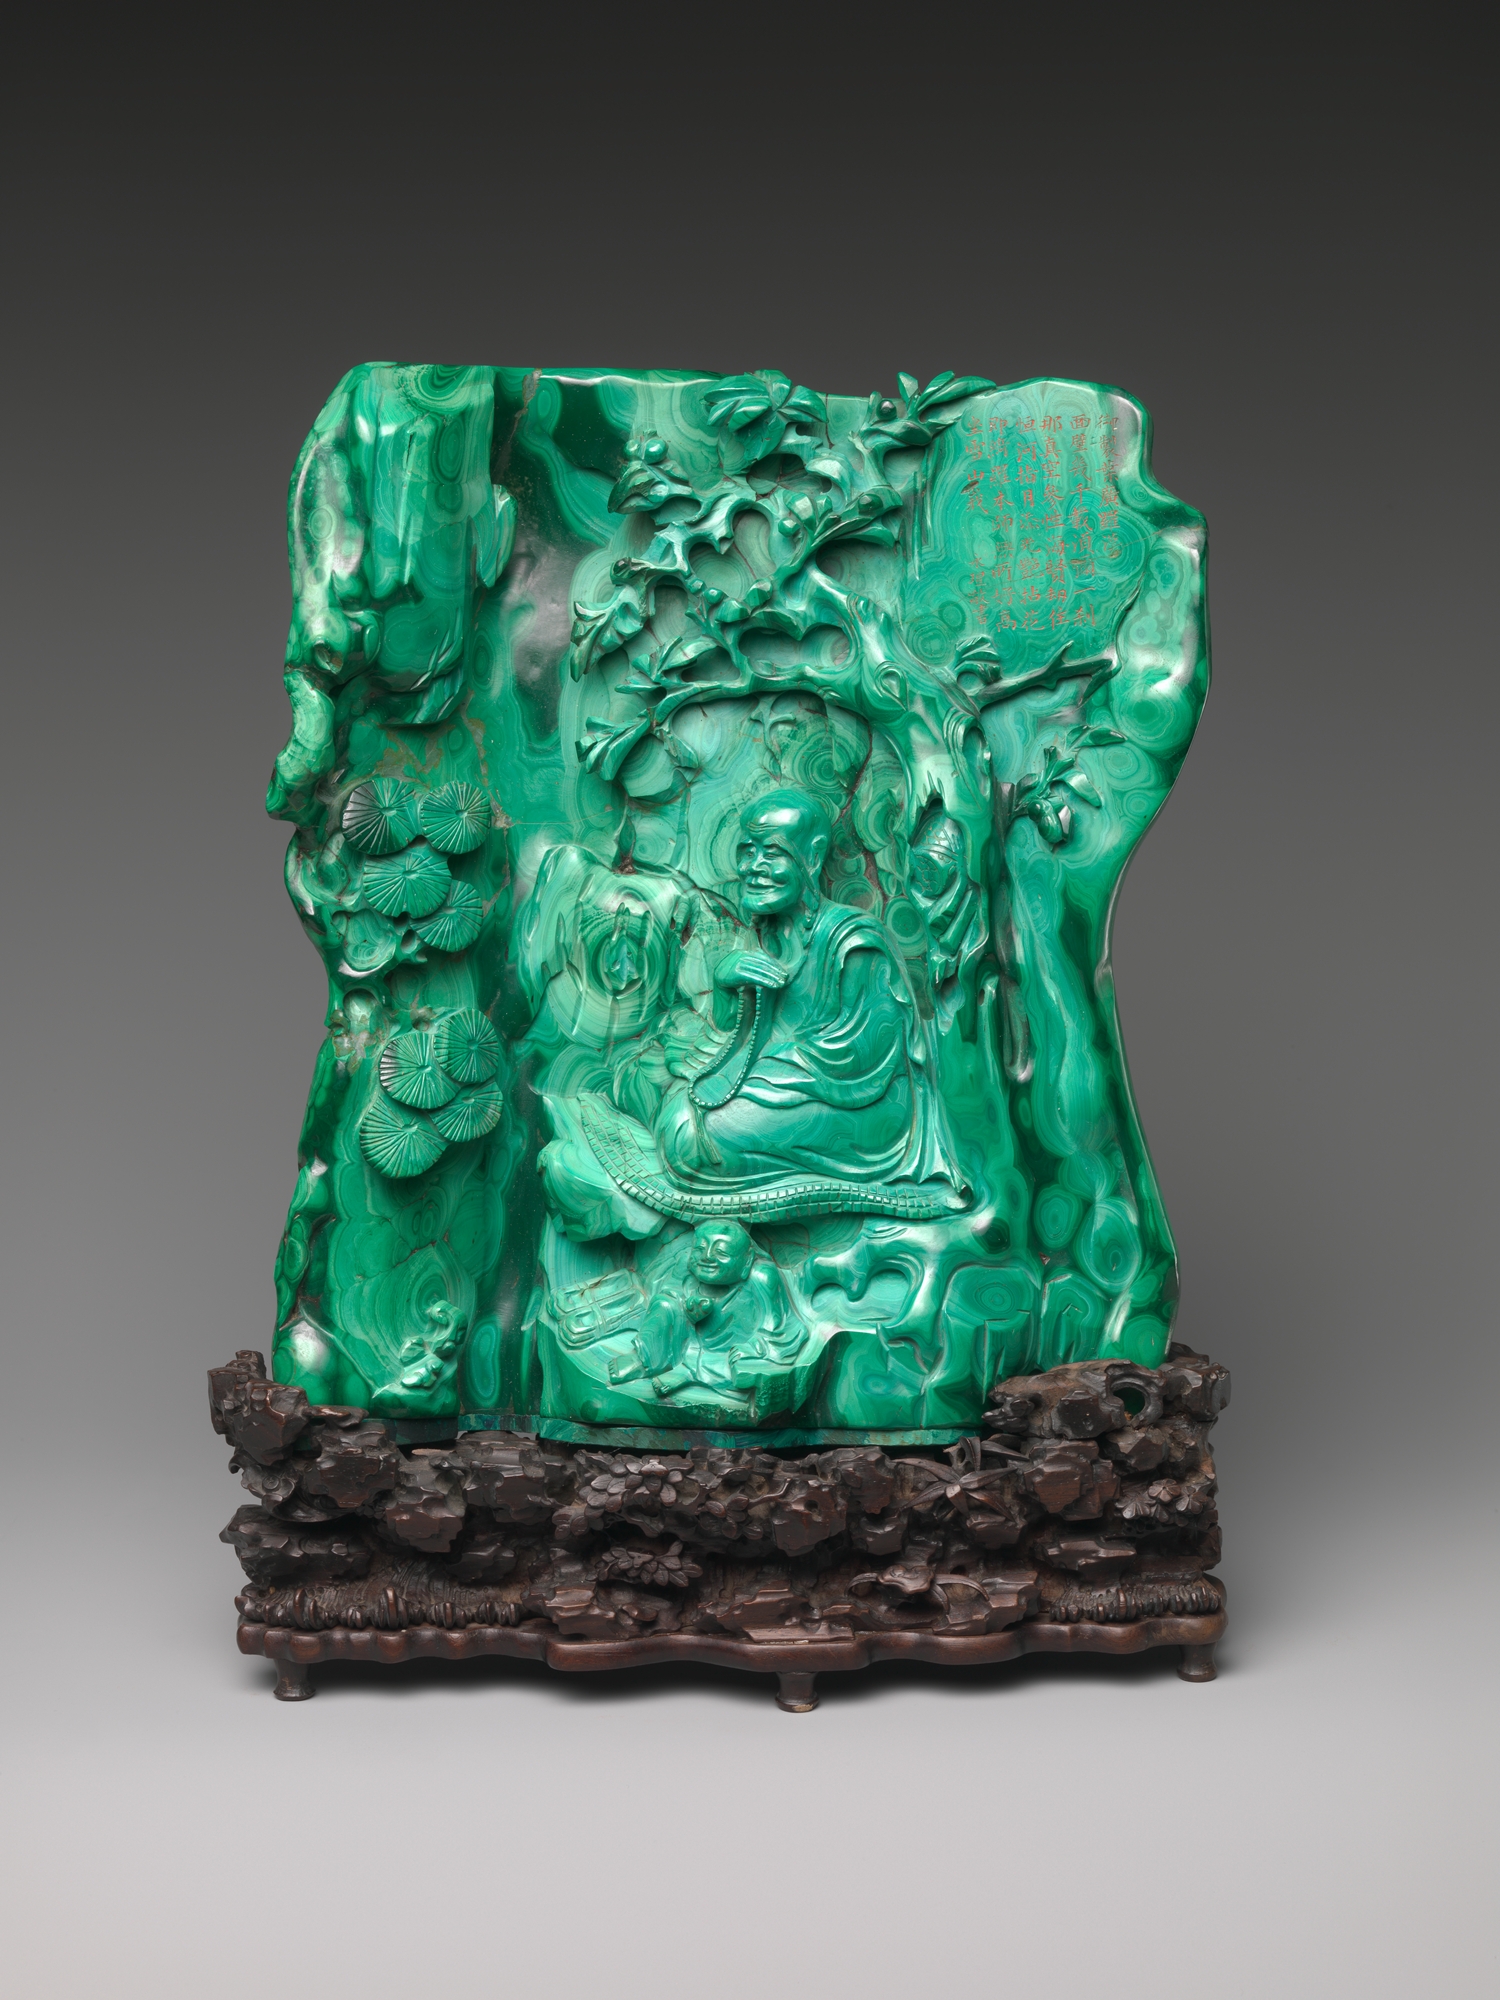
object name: jade mountain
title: Seated luohan with a servant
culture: chinese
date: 1767-1833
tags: men,buddhism